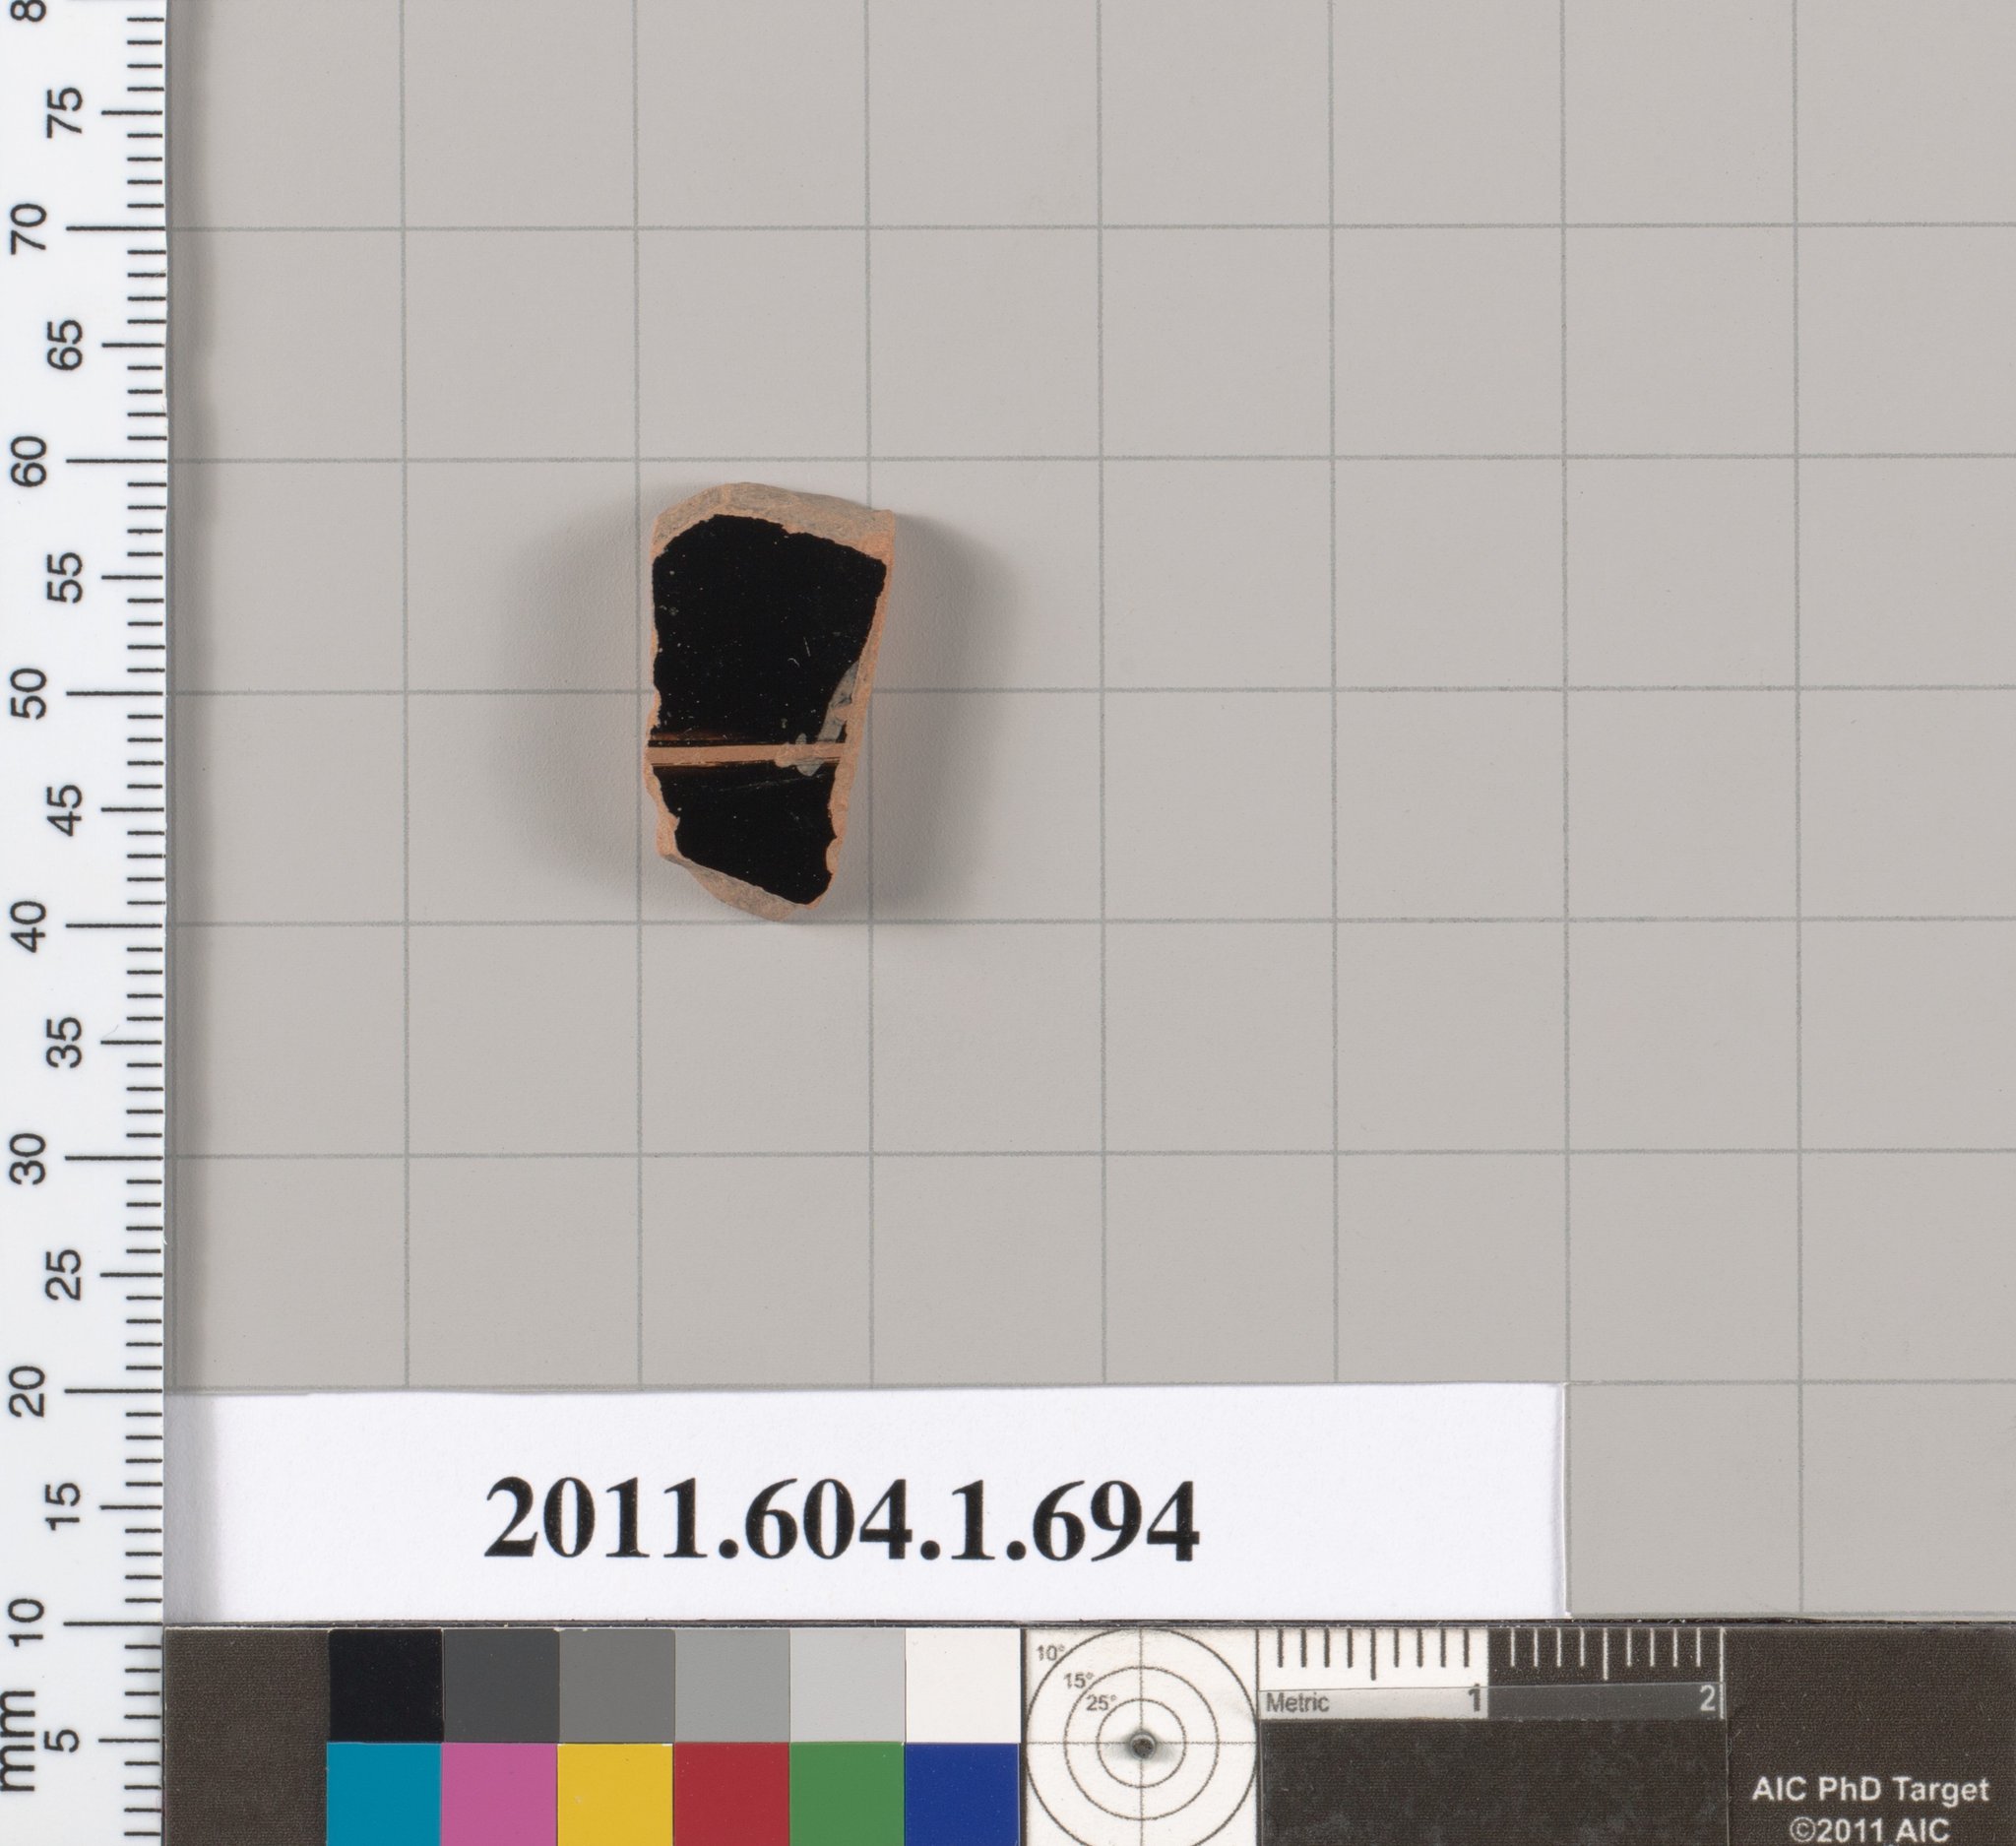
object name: kylix fragment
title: Terracotta fragment of a kylix (drinking cup)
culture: greek, attic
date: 475-451 BCE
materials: terracotta